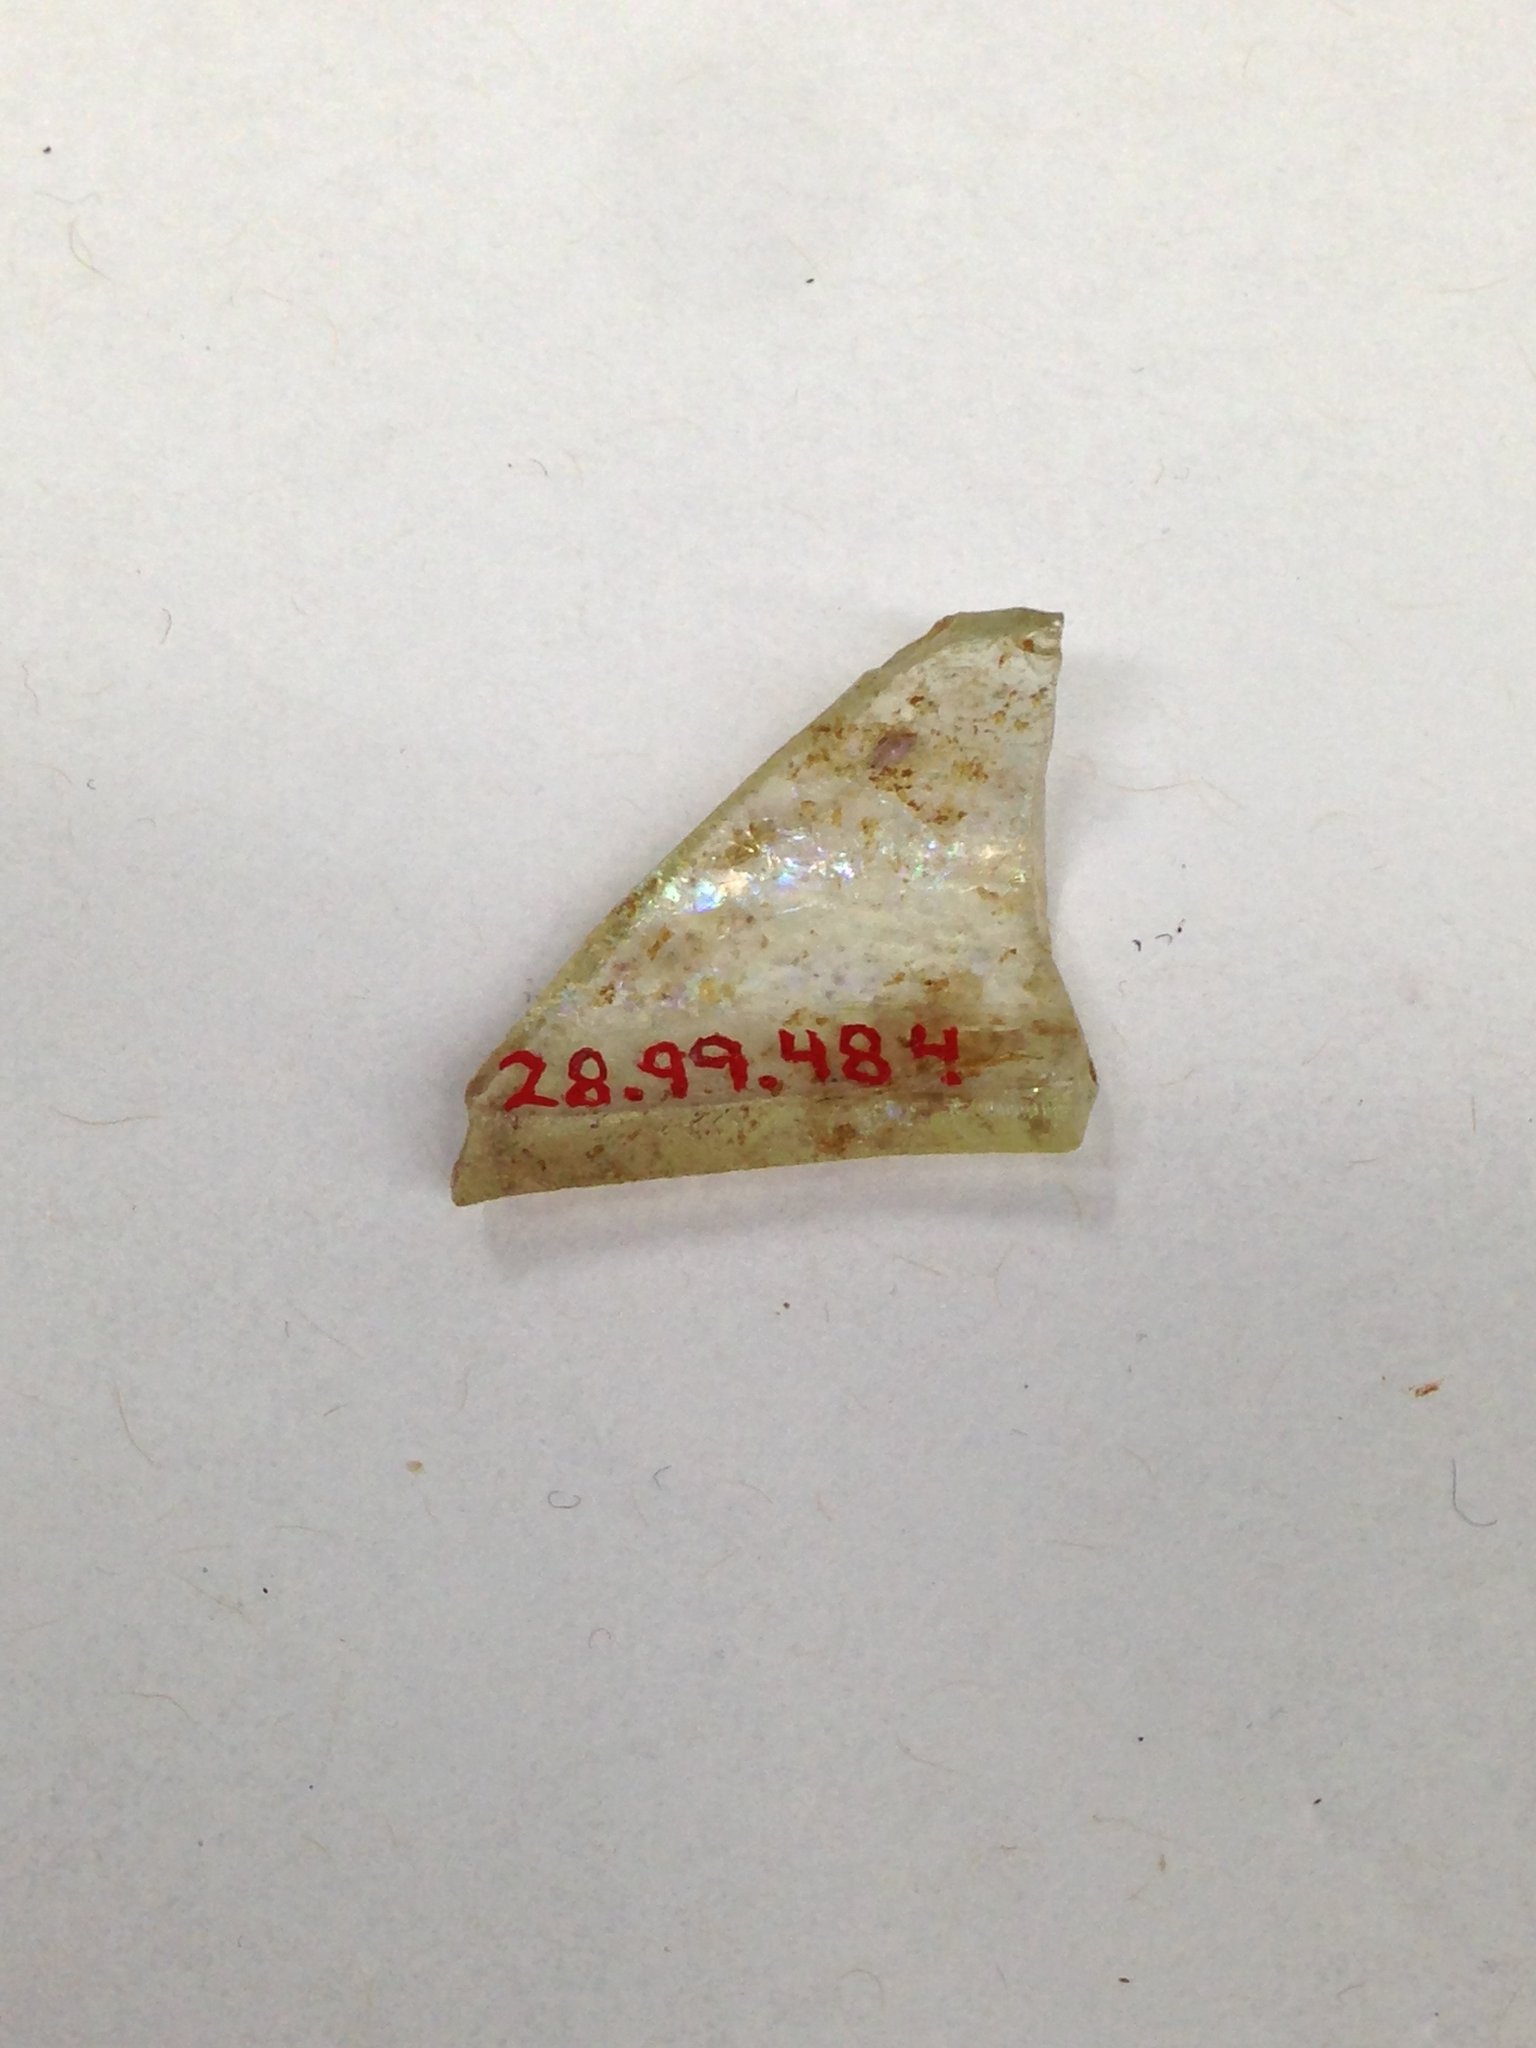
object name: fragment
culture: european or middle eastern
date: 1150-1250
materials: ceramic, glass